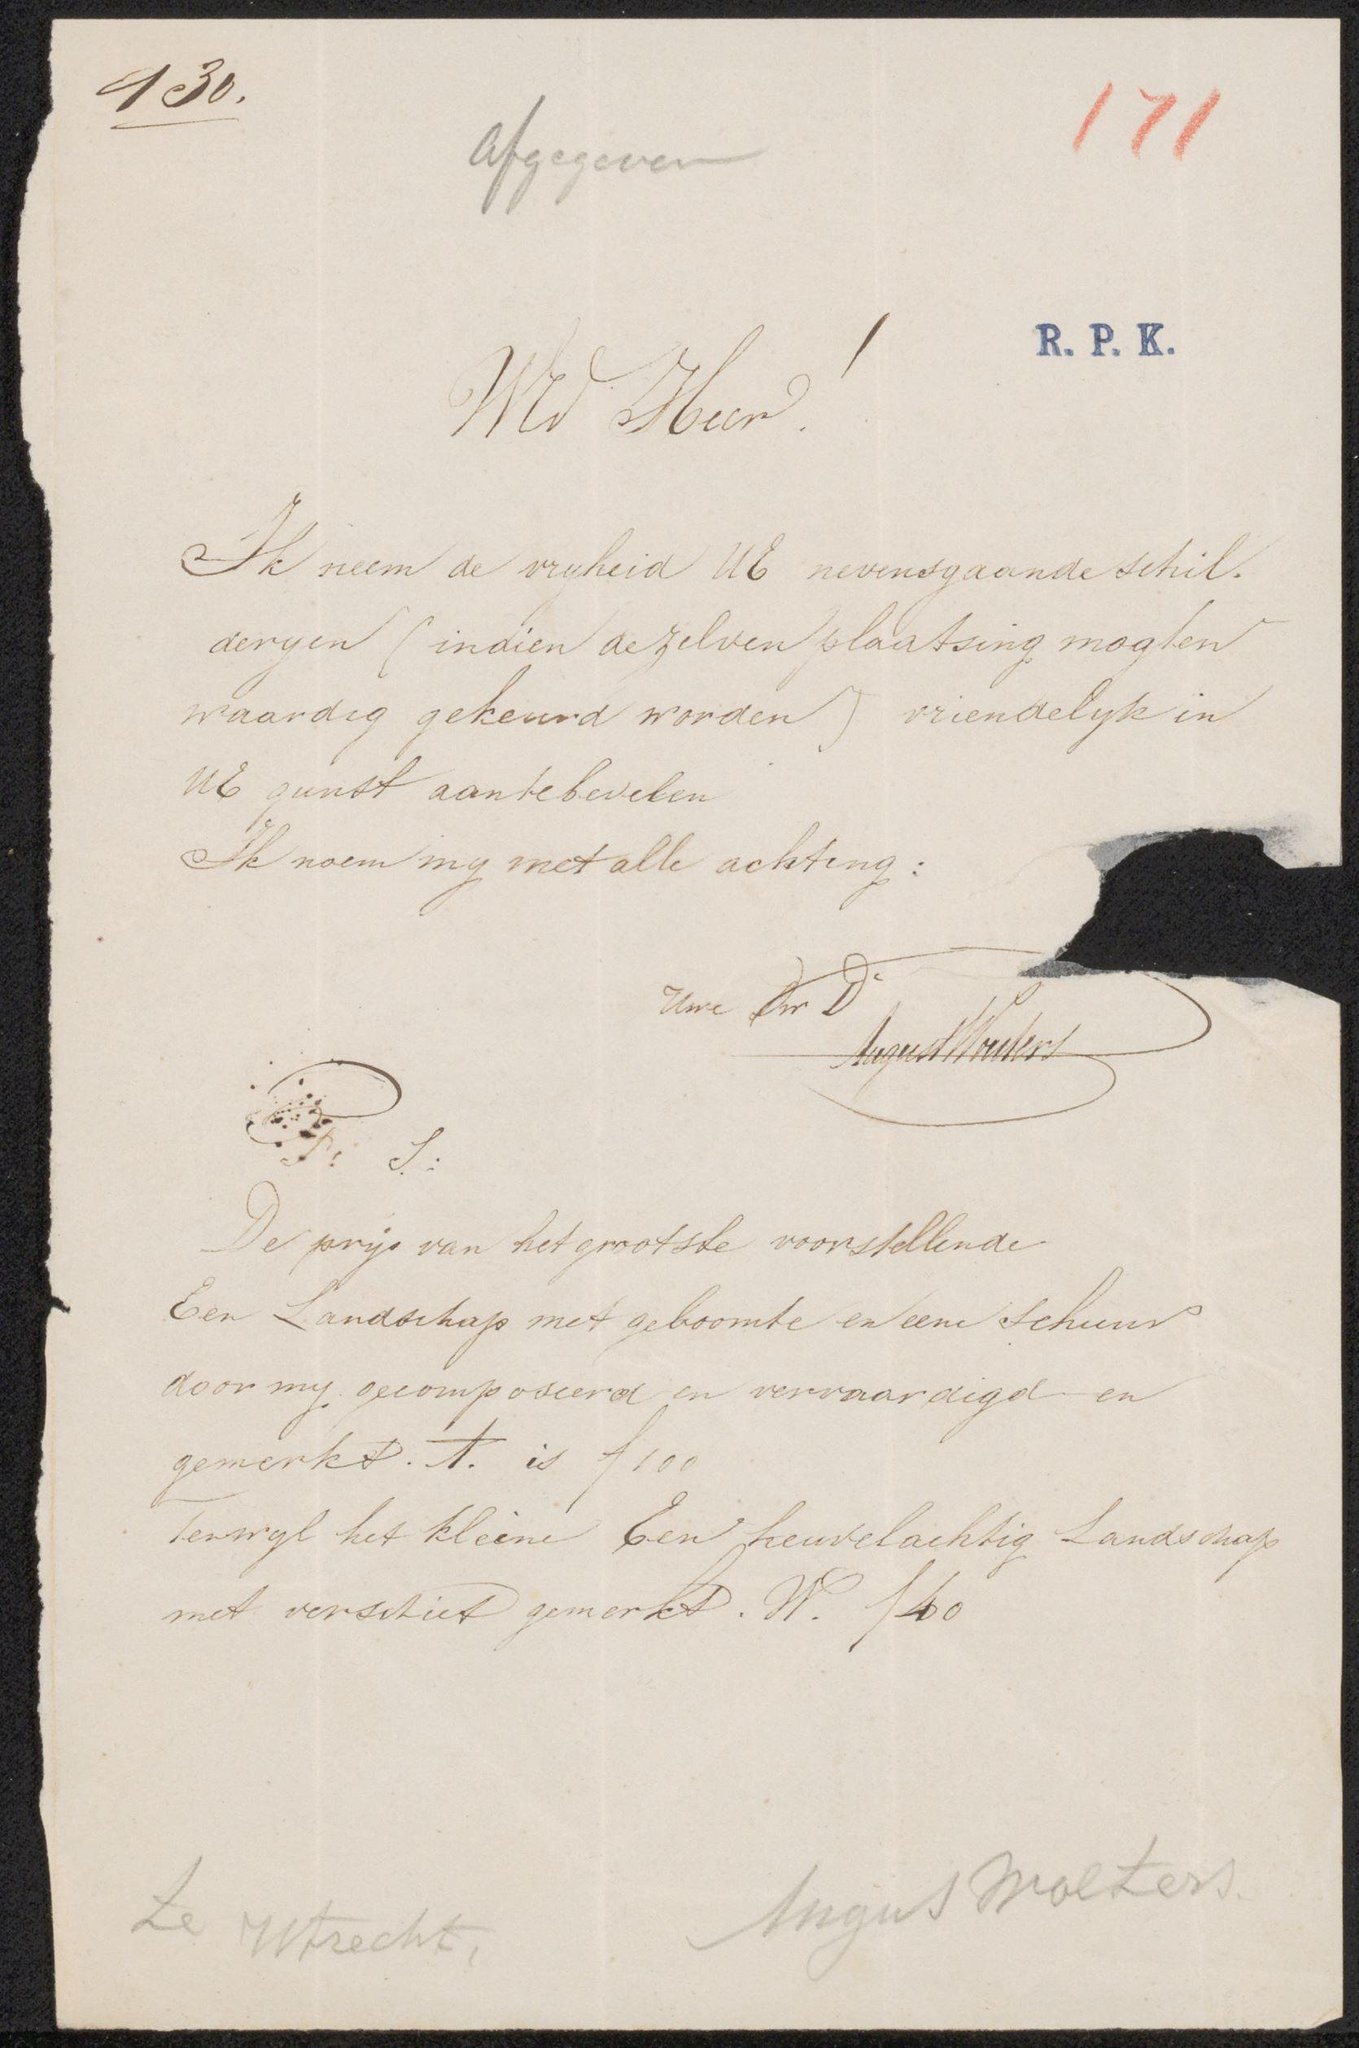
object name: letter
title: Brief aan anoniem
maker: augustinus jacobus bernardus wouters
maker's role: print maker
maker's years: 1829-1904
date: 1866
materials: ink, paper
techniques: pen, writing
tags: painting (including book-illumination, miniature-painting), money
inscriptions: collector's mark: Lugt 2233